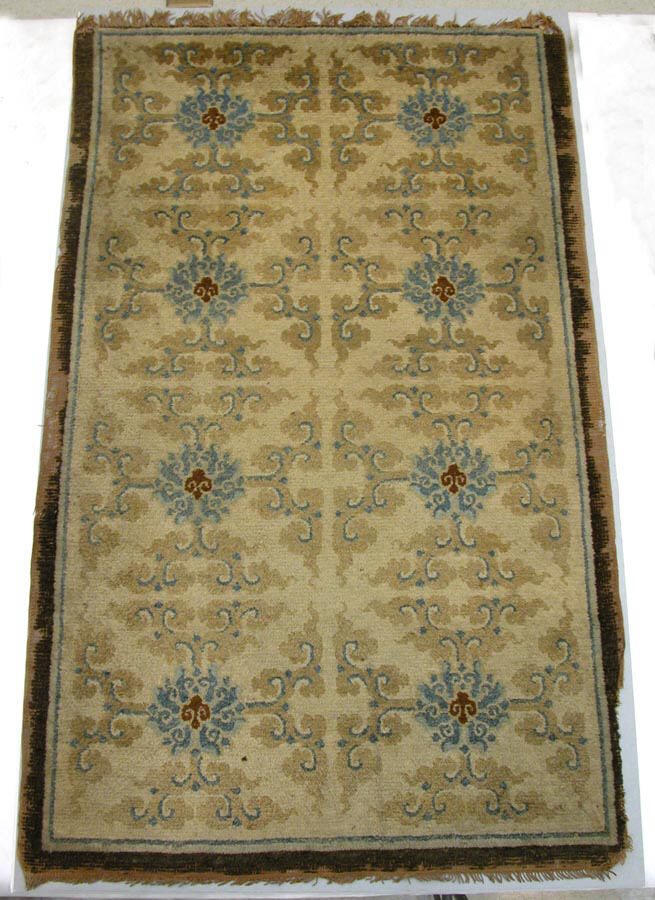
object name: rug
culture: chinese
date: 1701-1800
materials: cotton, wool